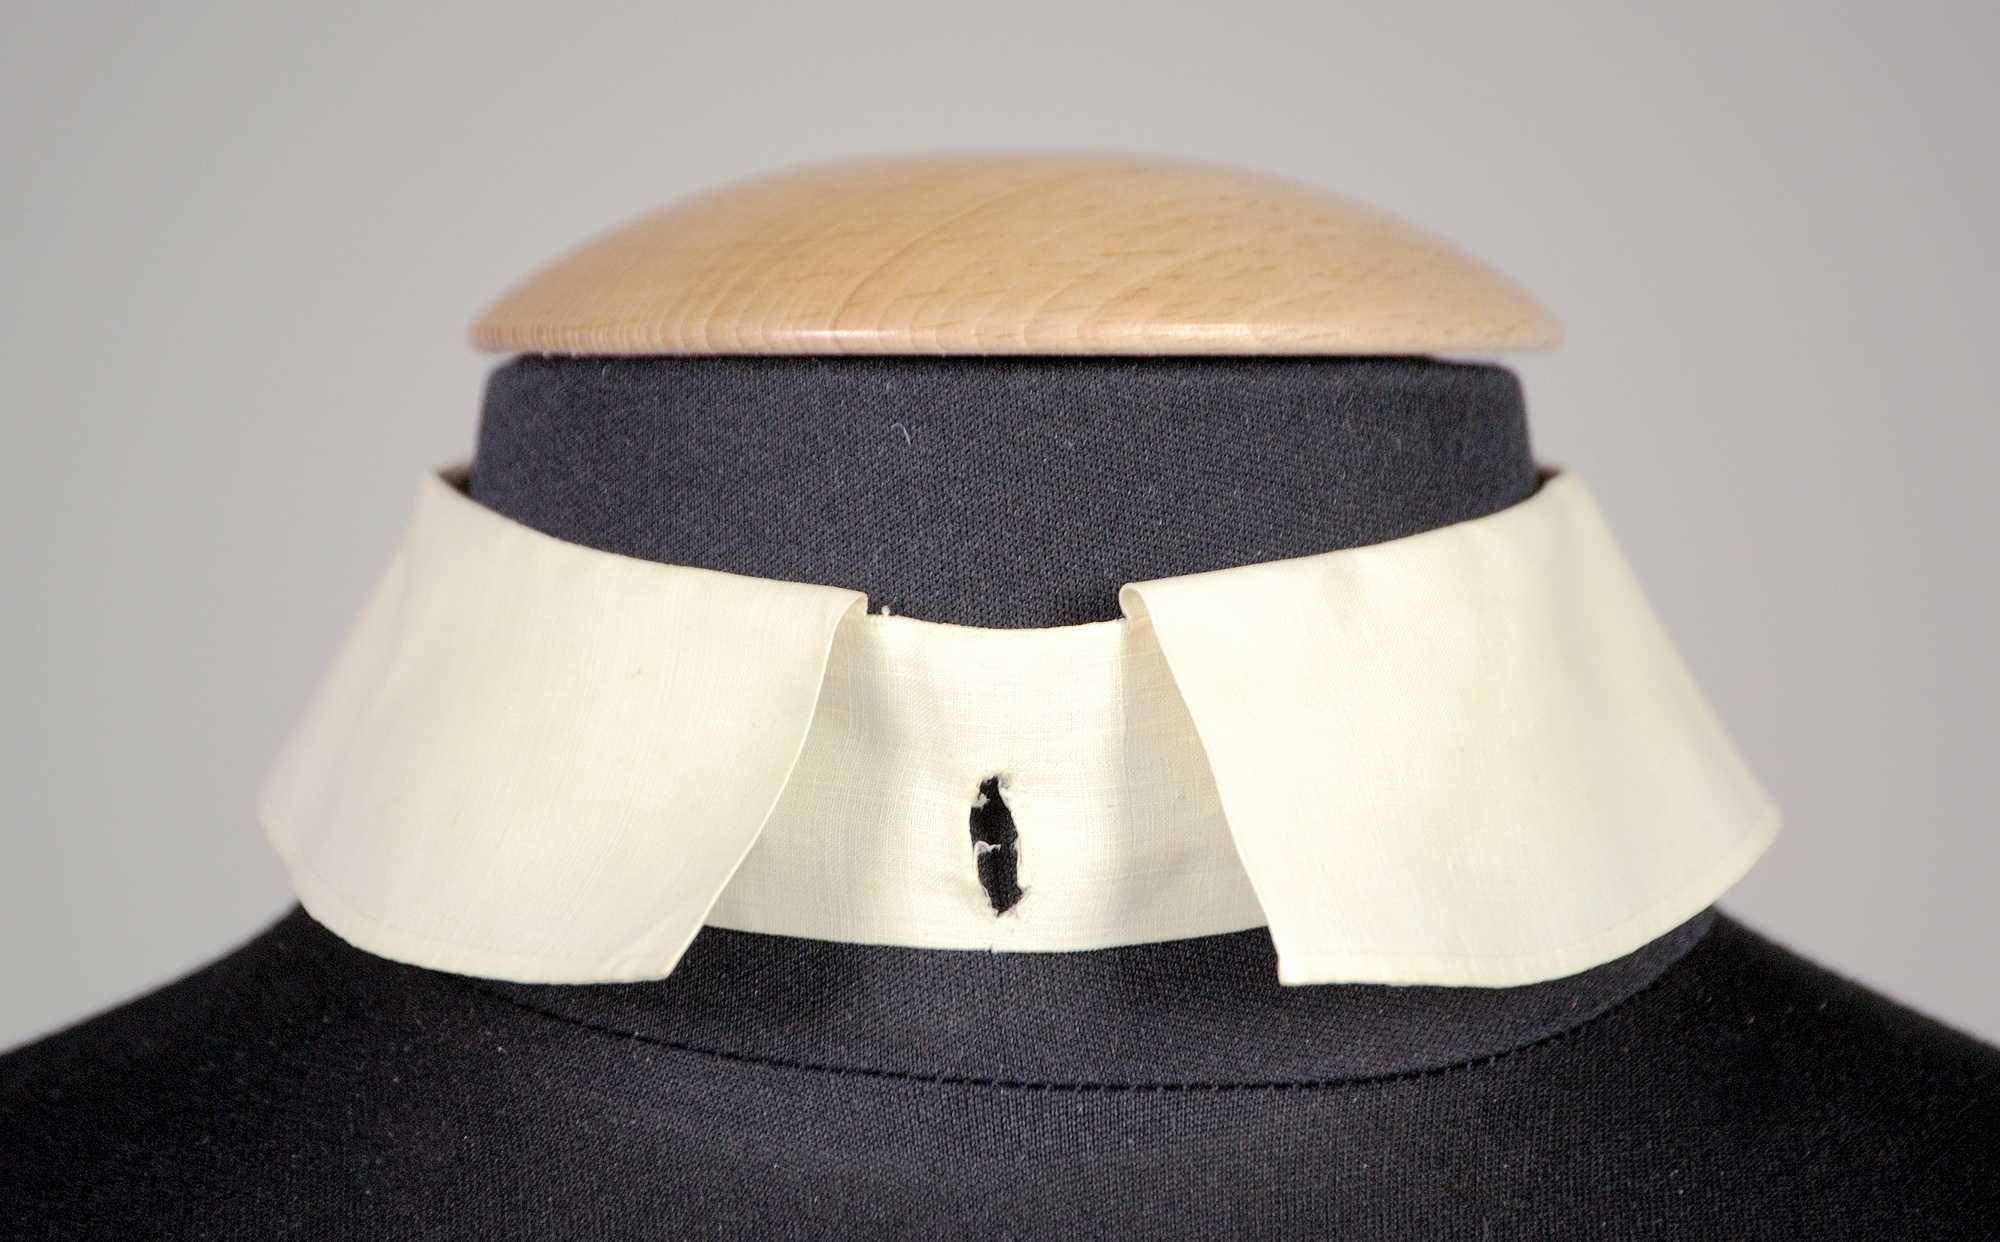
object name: collar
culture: american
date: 1848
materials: cotton